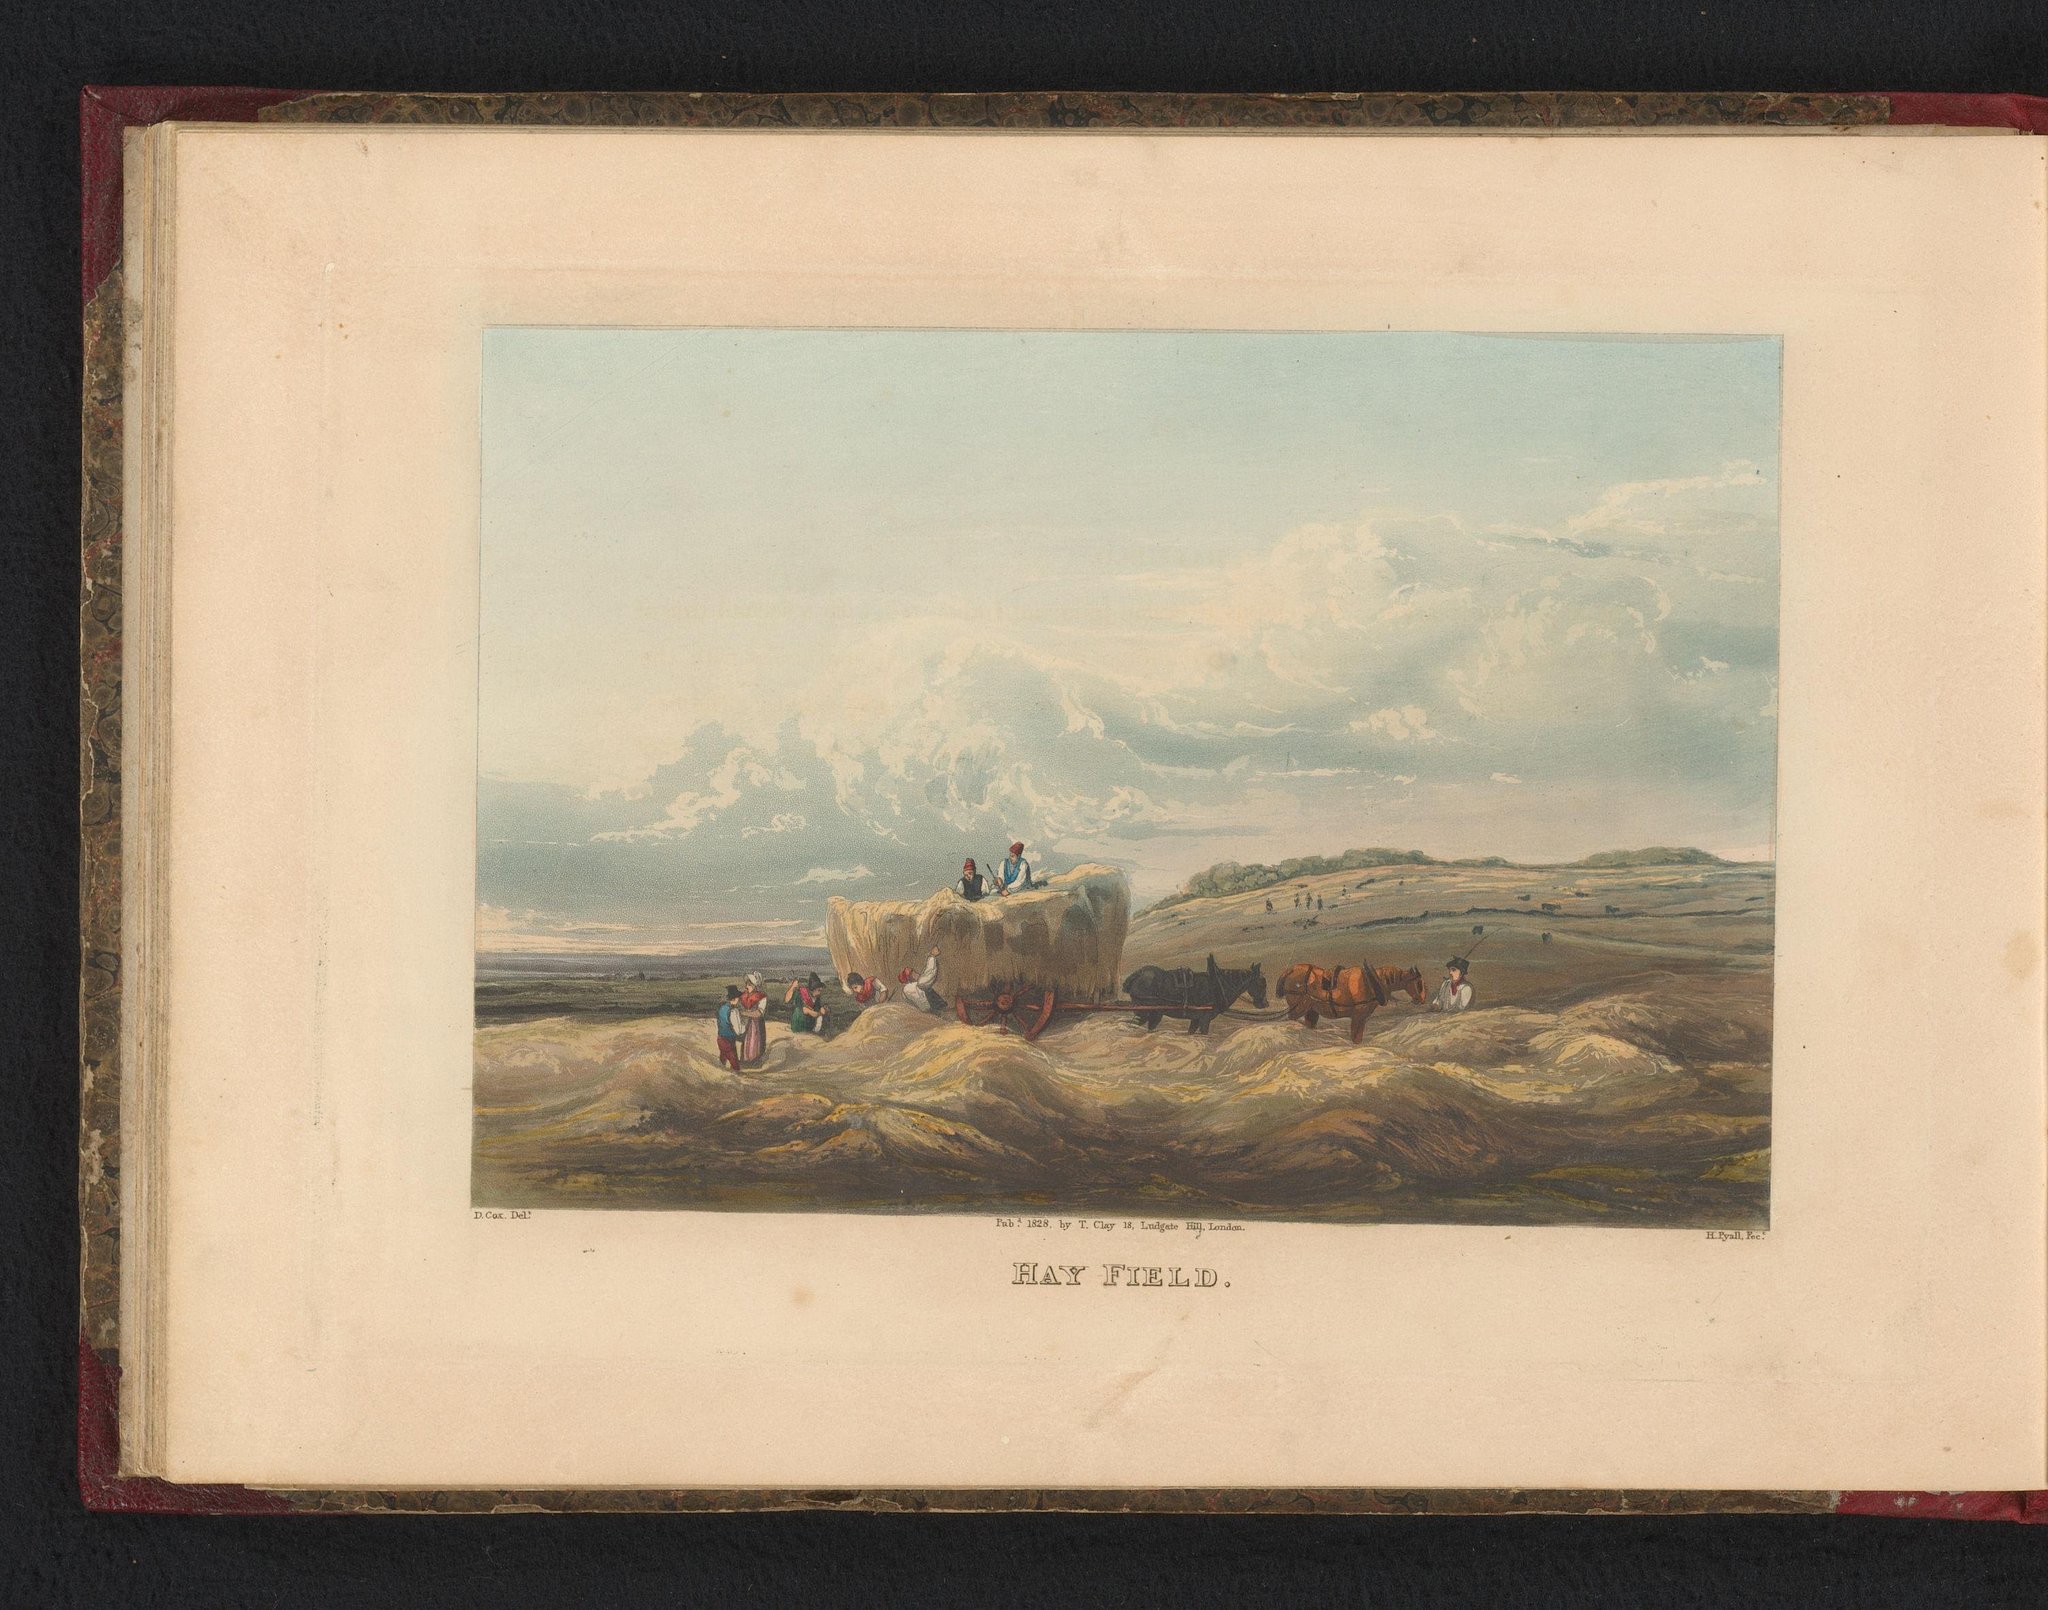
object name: print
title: Hay Field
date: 1828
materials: paper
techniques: aquatint, etching, hand coloring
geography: london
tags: harvest, low hill country (+ landscape with figures, staffage), painting (including book-illumination, miniature-painting), hay-wagon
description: Prent is gedrukt op de pagina tegenover pagina 31.